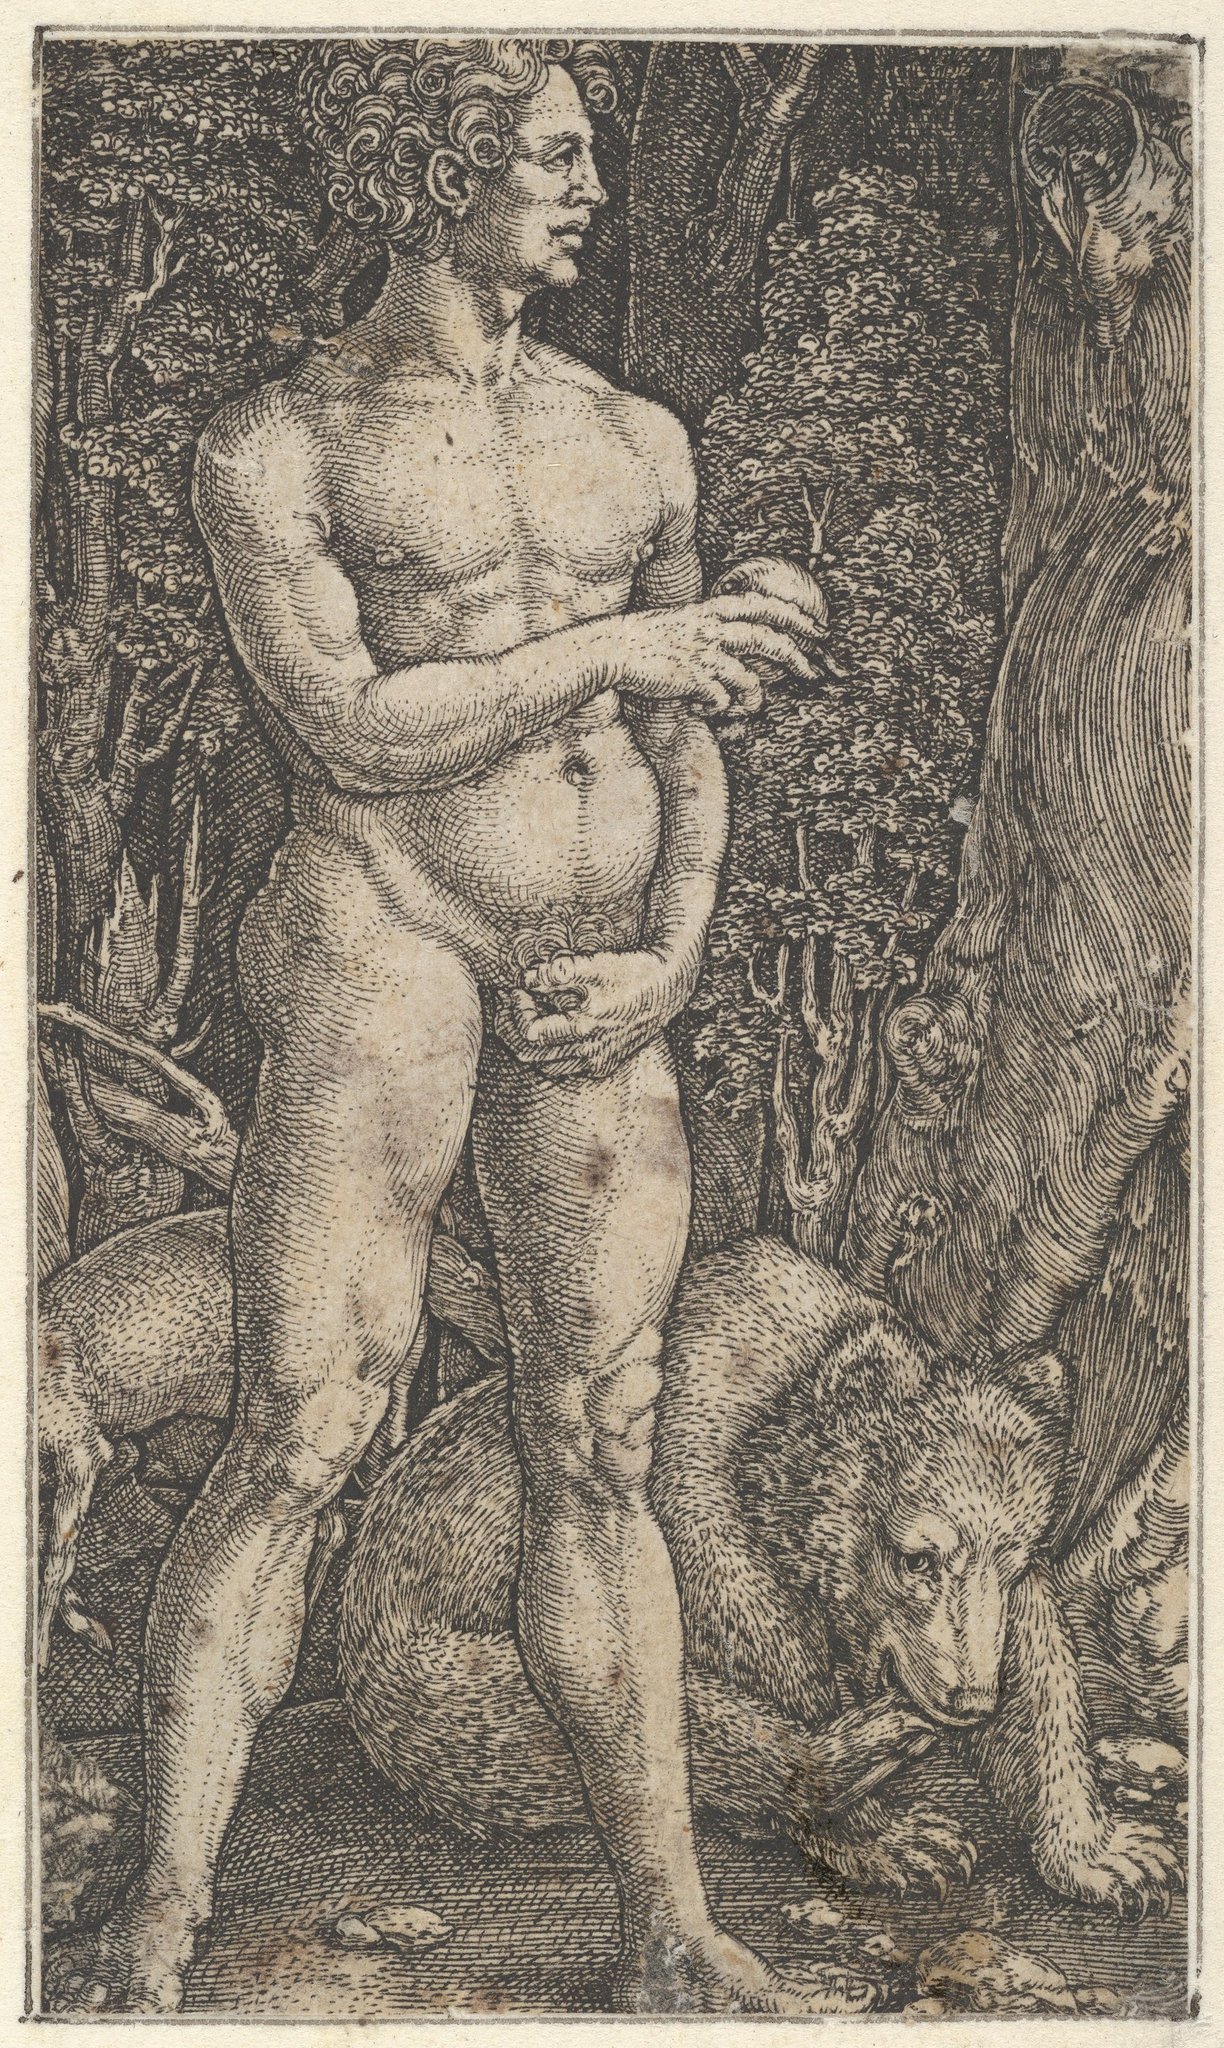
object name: print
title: Adam with a Bear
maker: heinrich aldegrever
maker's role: artist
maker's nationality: german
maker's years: 1502-1561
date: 1529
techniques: engraving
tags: bears,adam